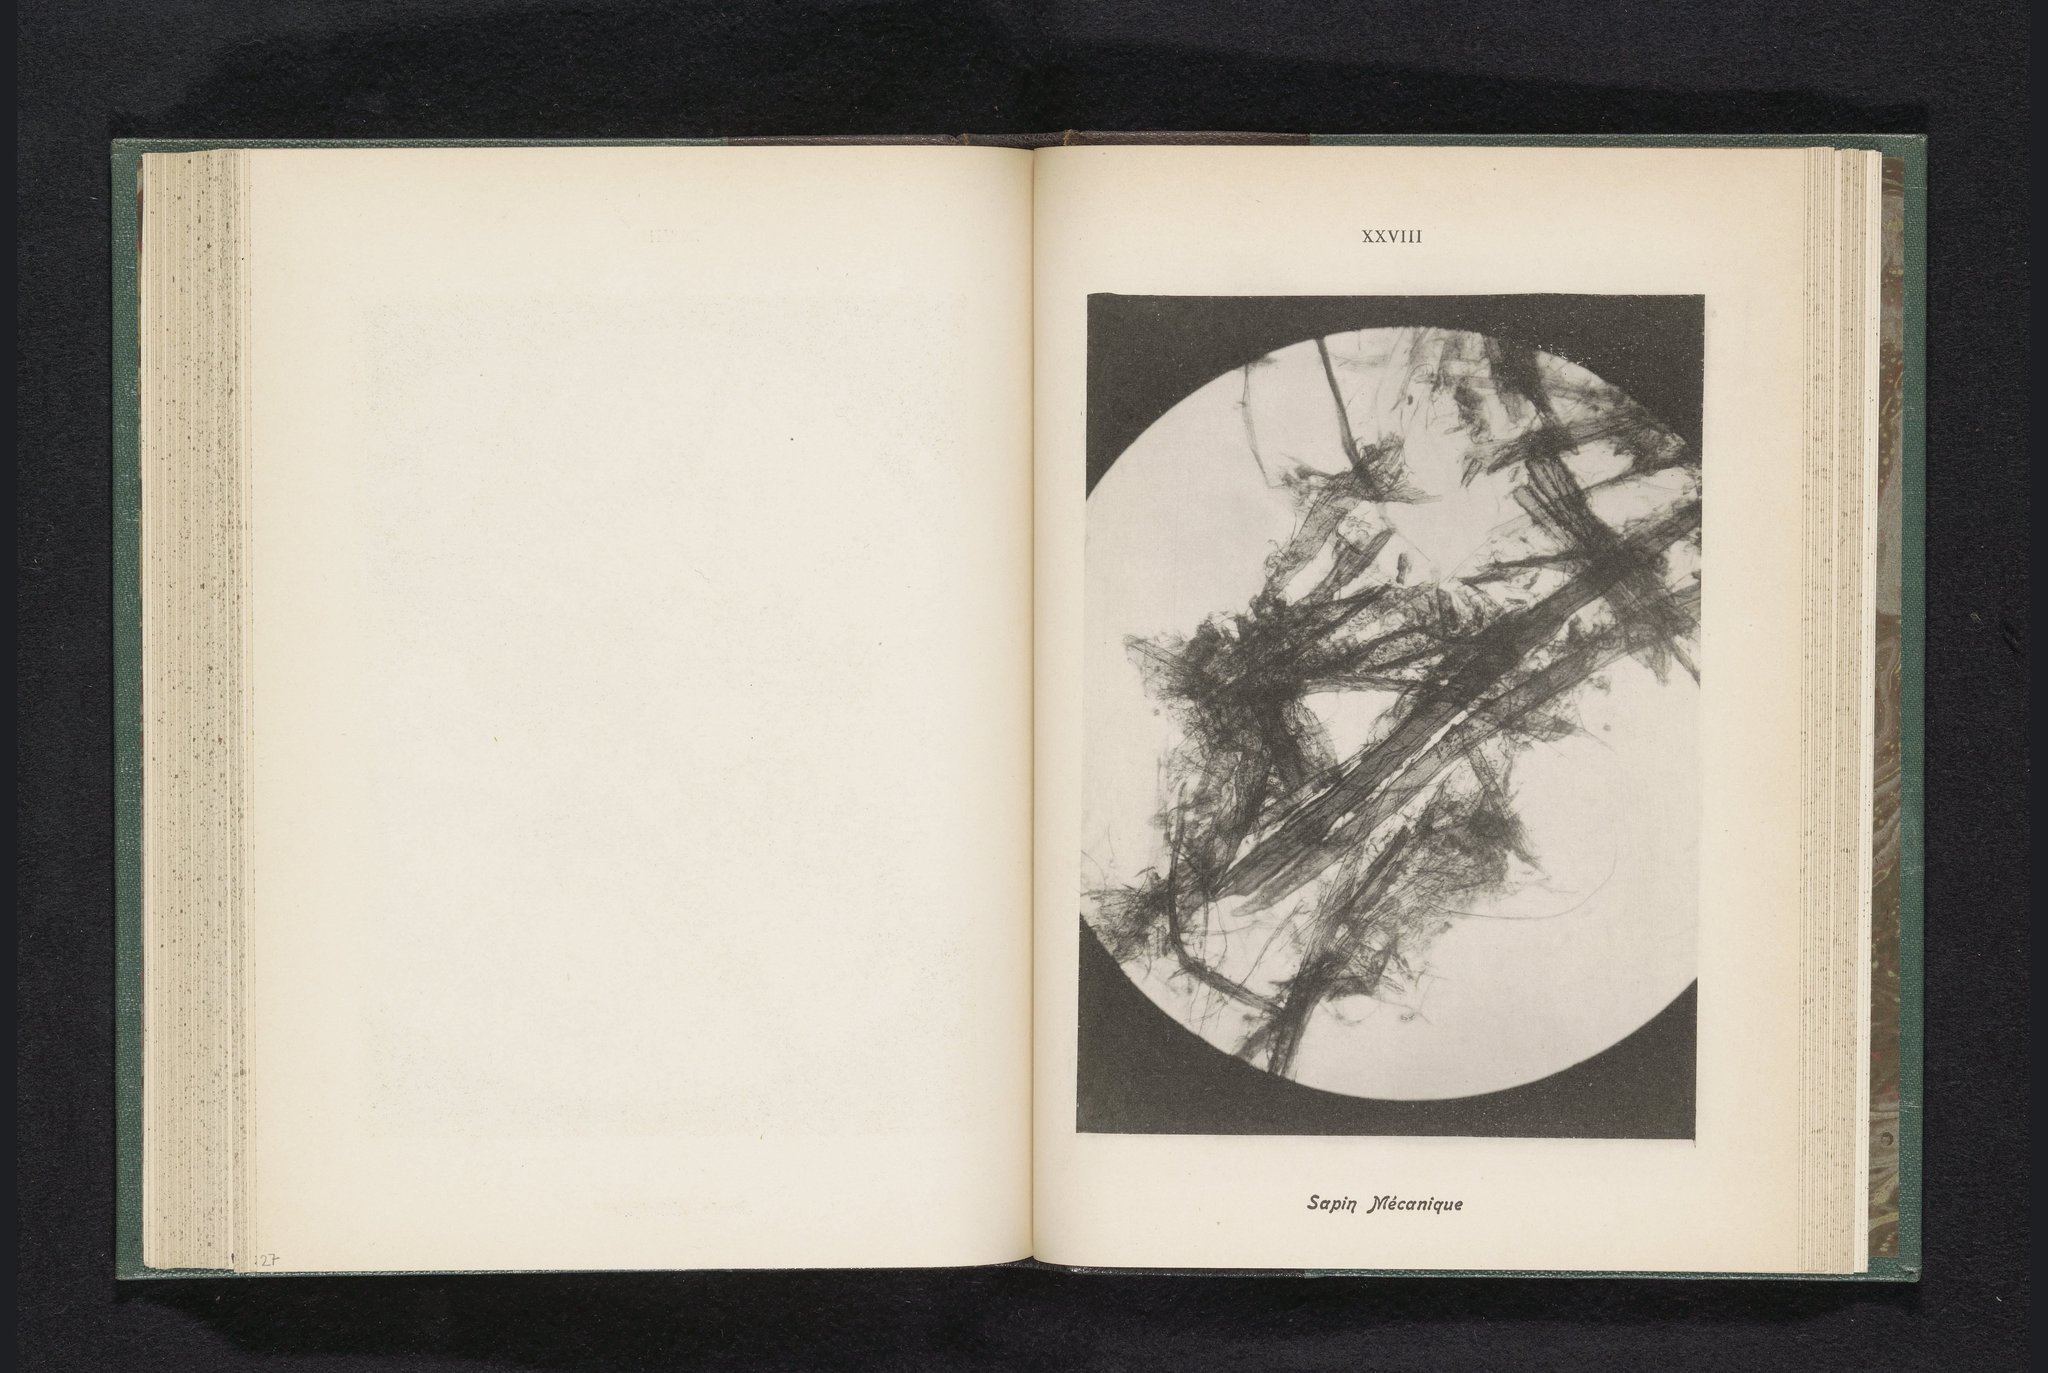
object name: photomechanical print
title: Micro-opname van de vezels van vermoedelijk een spar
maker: Anonymous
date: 1890-1900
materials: paper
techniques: photograph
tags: trees: fir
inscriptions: number: ‘XXVIII’